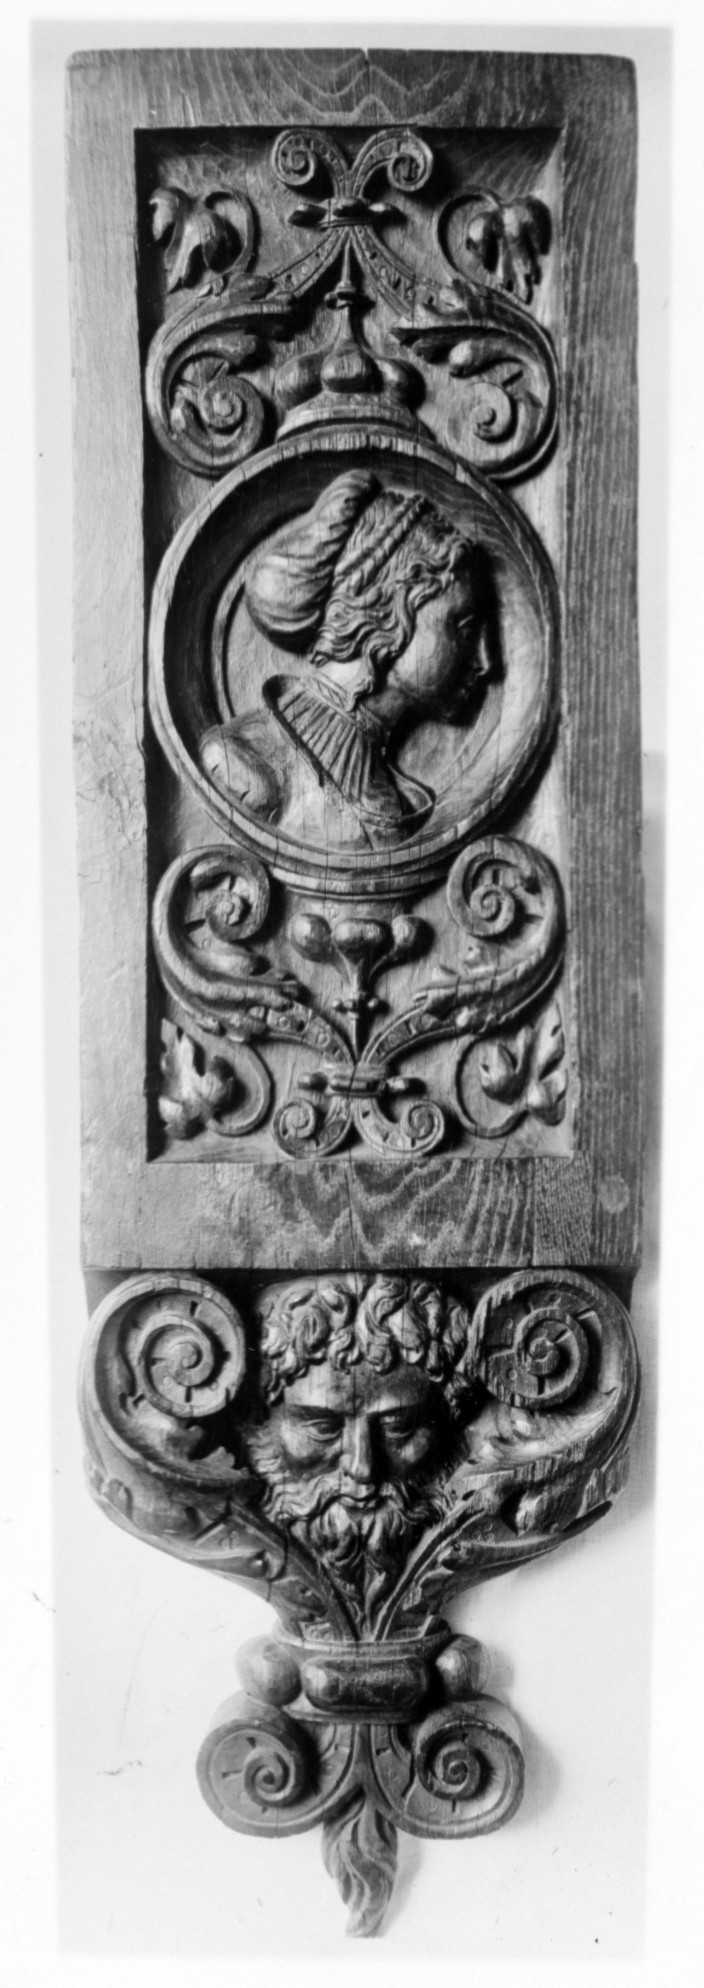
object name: panel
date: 1501-1600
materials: wood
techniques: carving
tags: heads,men,profiles,women